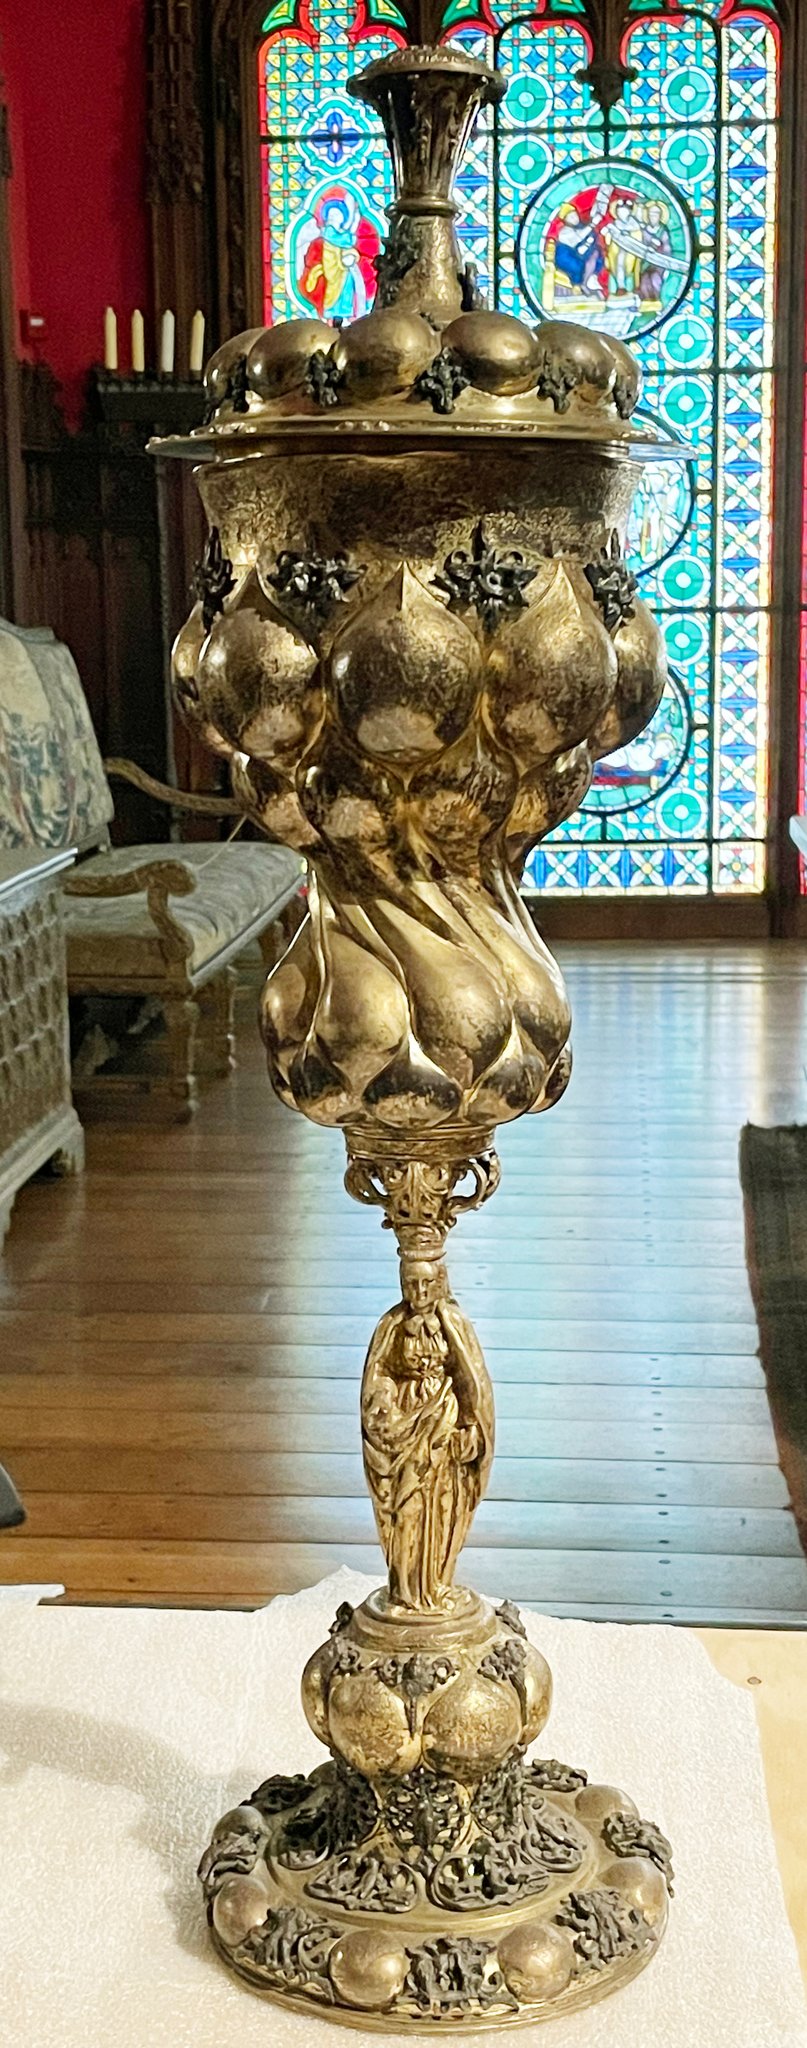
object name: standing cup with cover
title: Standing cup with cover (Hanap)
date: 1801-1900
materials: metal, silver